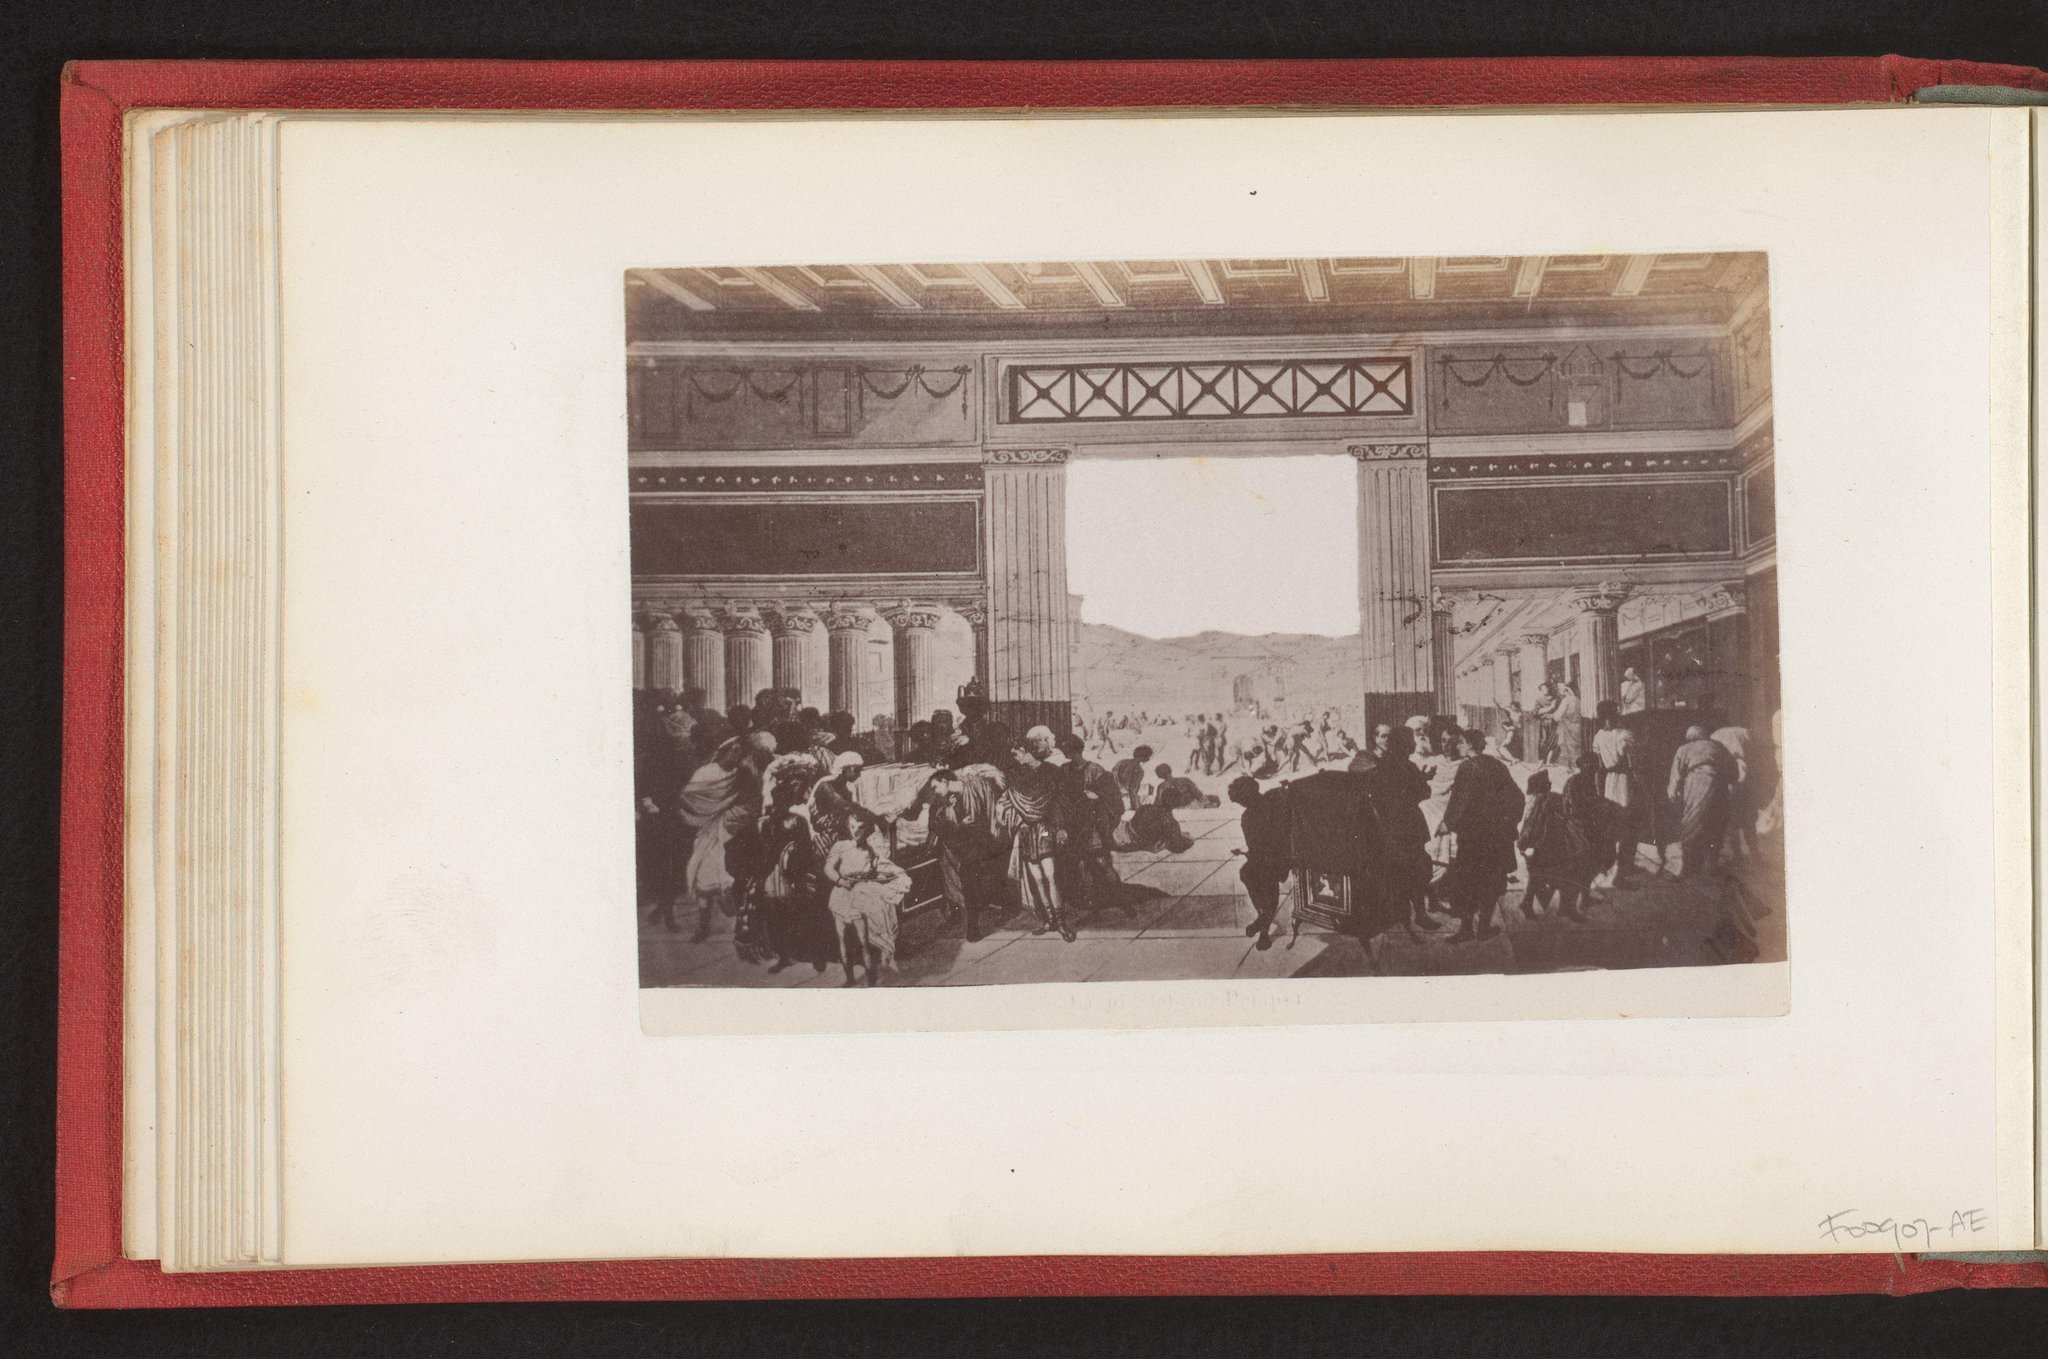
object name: reproduction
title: Bagni Stabiane, Pompeï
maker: Anonymous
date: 1860-1900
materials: photographic support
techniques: albumen print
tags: the graphic arts, public baths